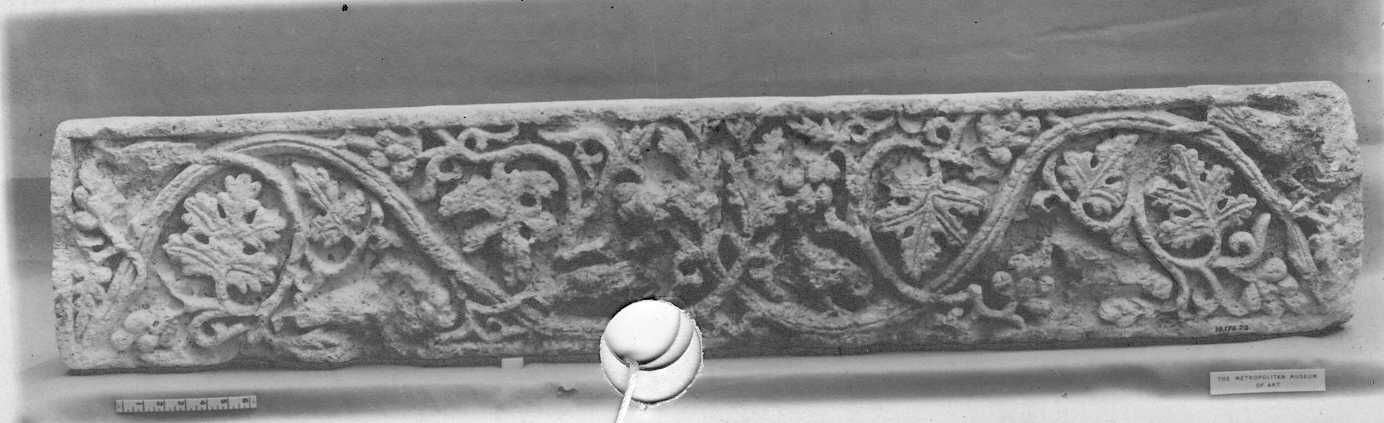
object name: frieze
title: Frieze with Vine Scrolls and Birds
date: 501-600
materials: limestone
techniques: carving, relief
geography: egypt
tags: birds,vines